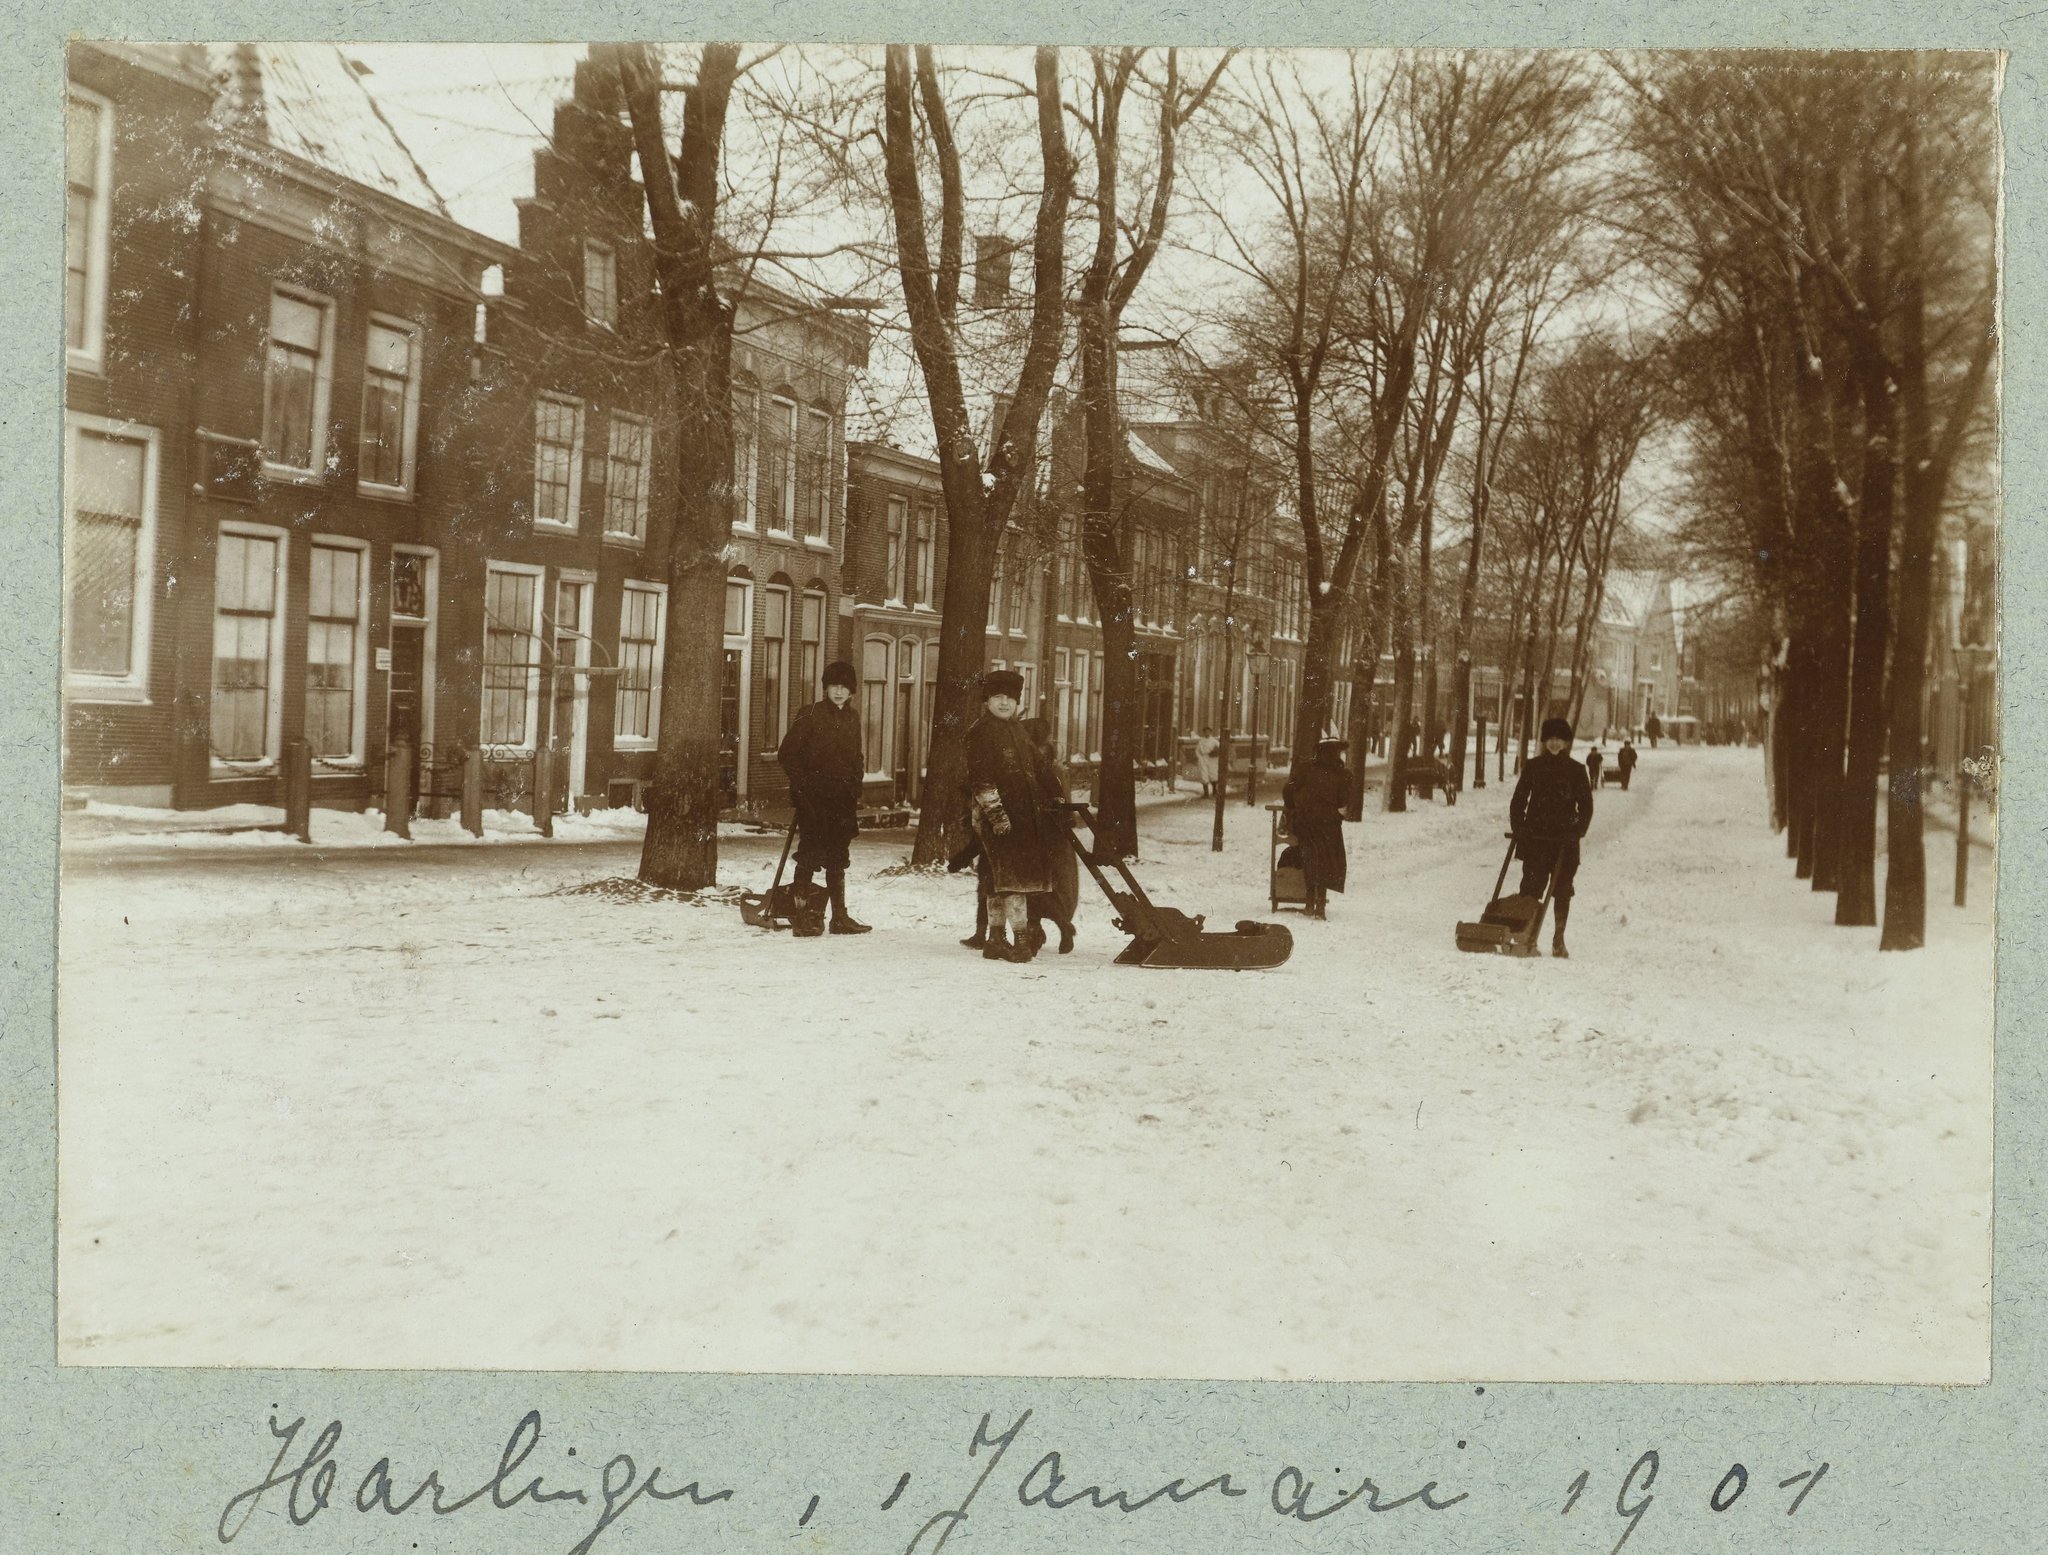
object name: photograph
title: Photographieën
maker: frits freerks fontein fz.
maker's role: fotograaf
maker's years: 1882-1928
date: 1901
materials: cardboard, paper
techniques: gelatin silver print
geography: netherlands